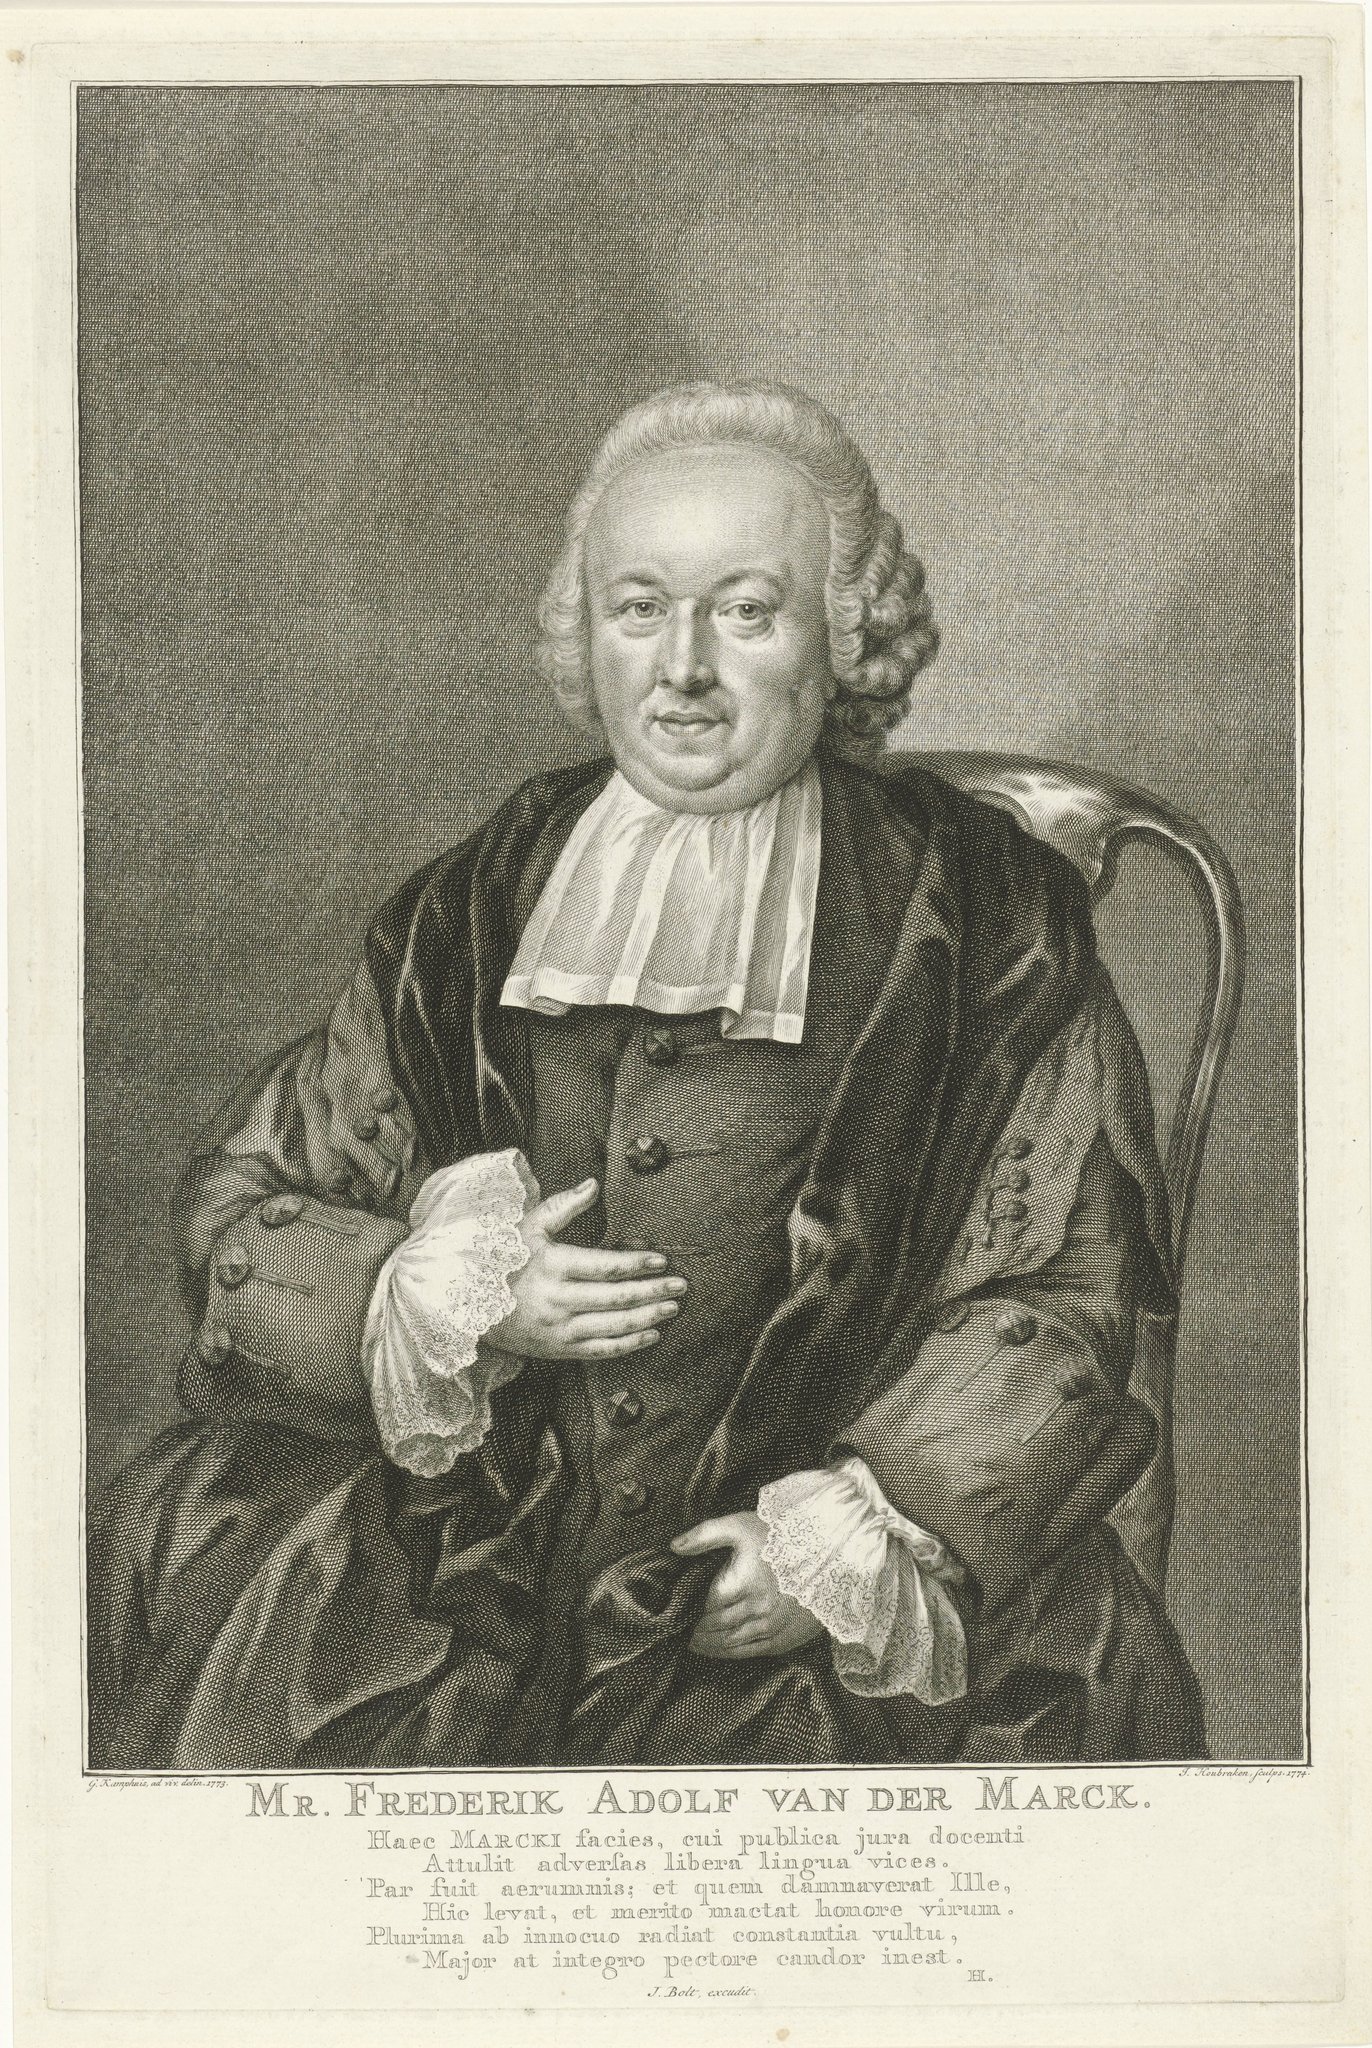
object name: print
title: Mr. Frederik Adolf van der Marck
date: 1774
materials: paper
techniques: engraving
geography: groningen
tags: professor, frederik adolph van der marck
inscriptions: collector's mark: Lugt 2228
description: Kniestuk van Frederik Adolph van der Marck, zittend op een stoel. Onder het portret zijn naam en een zesregelige tekst in het Latijn.